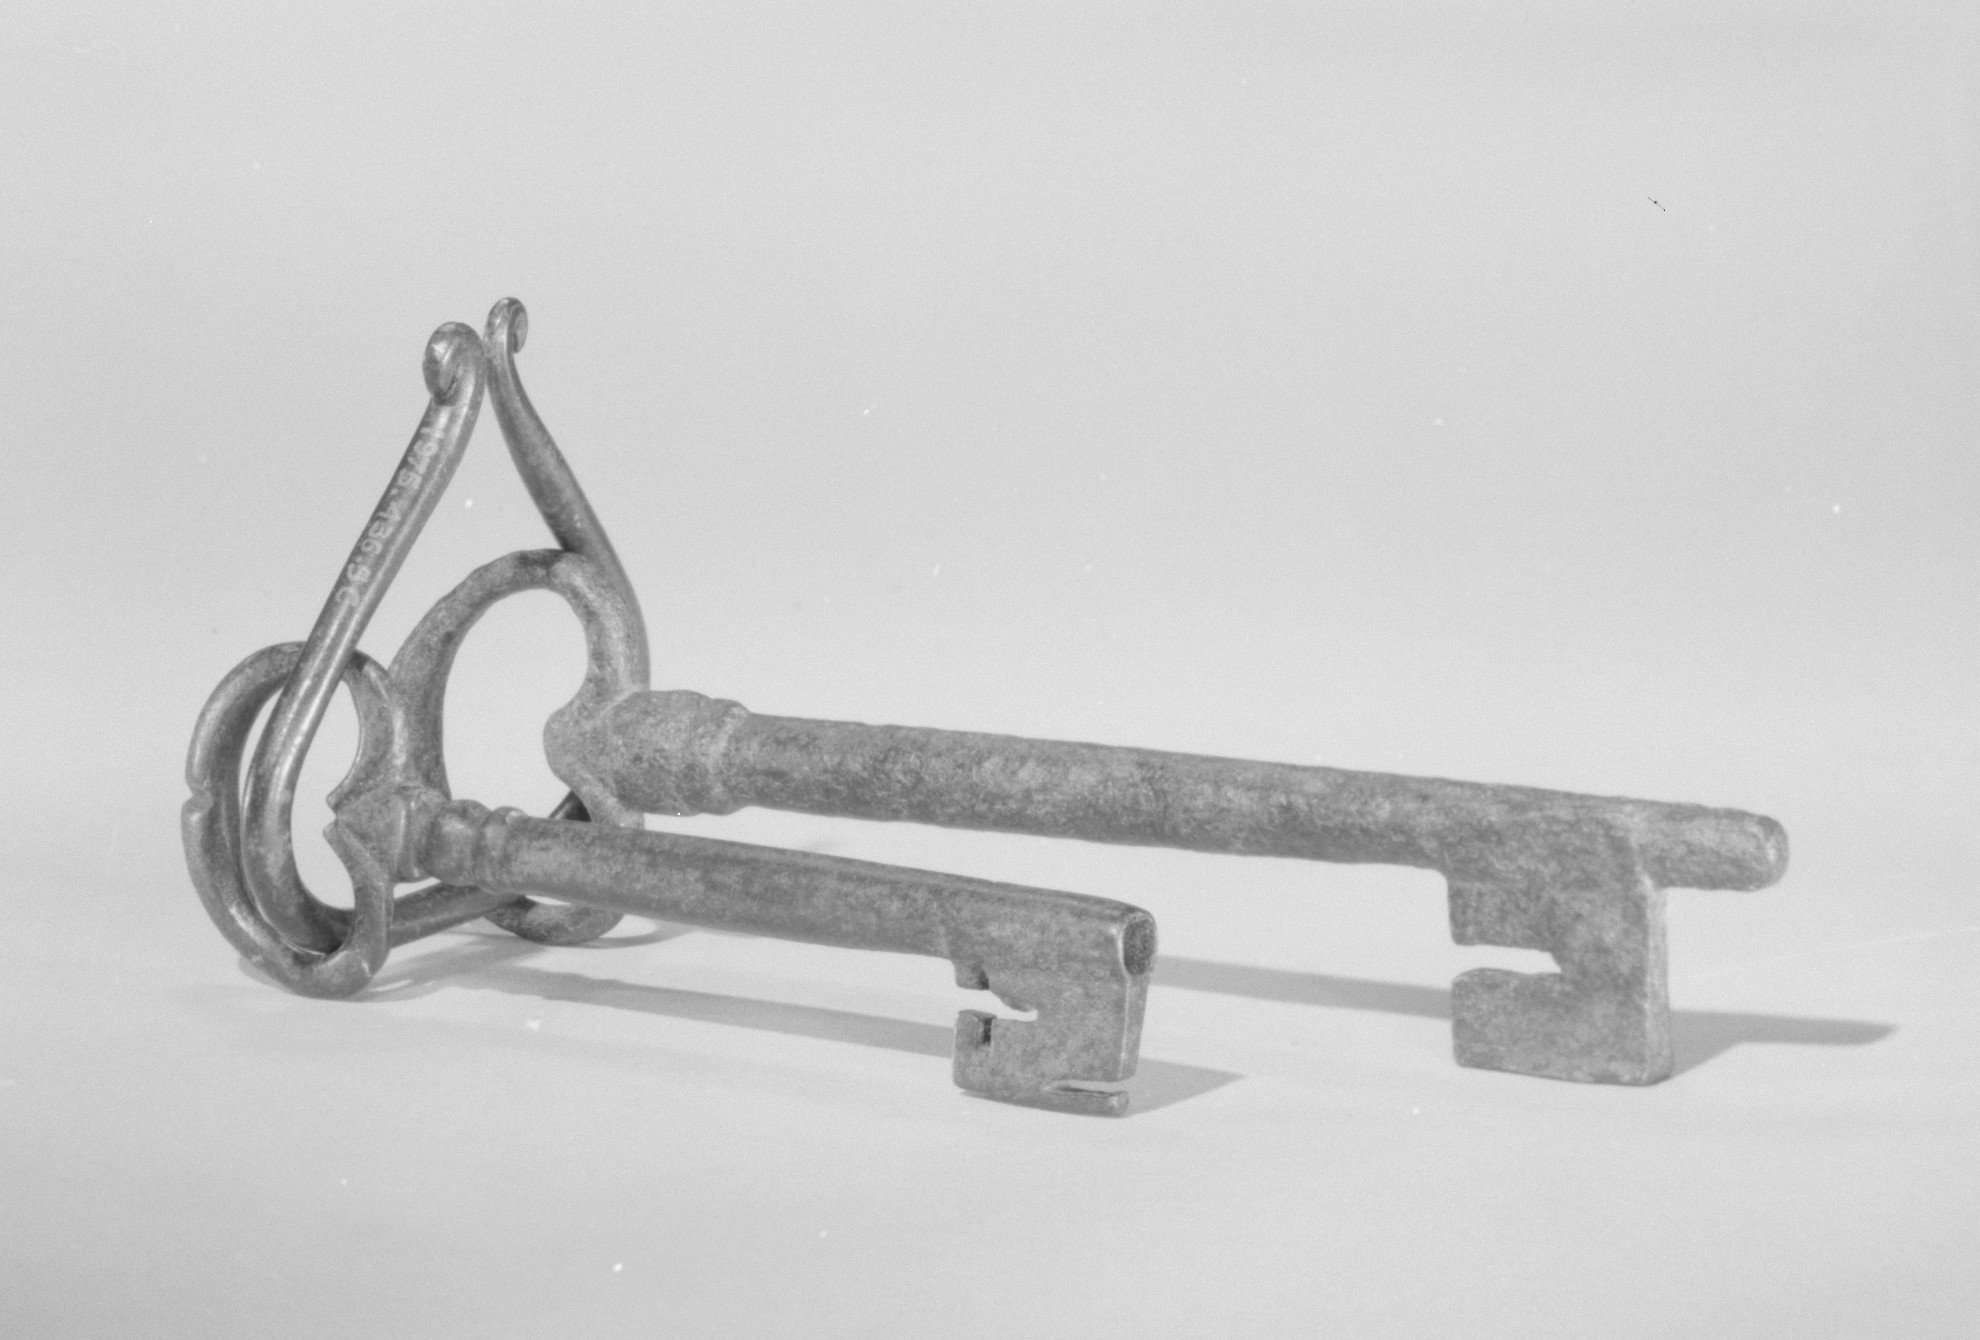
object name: key ring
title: Two keys and key ring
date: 1501-1700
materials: iron